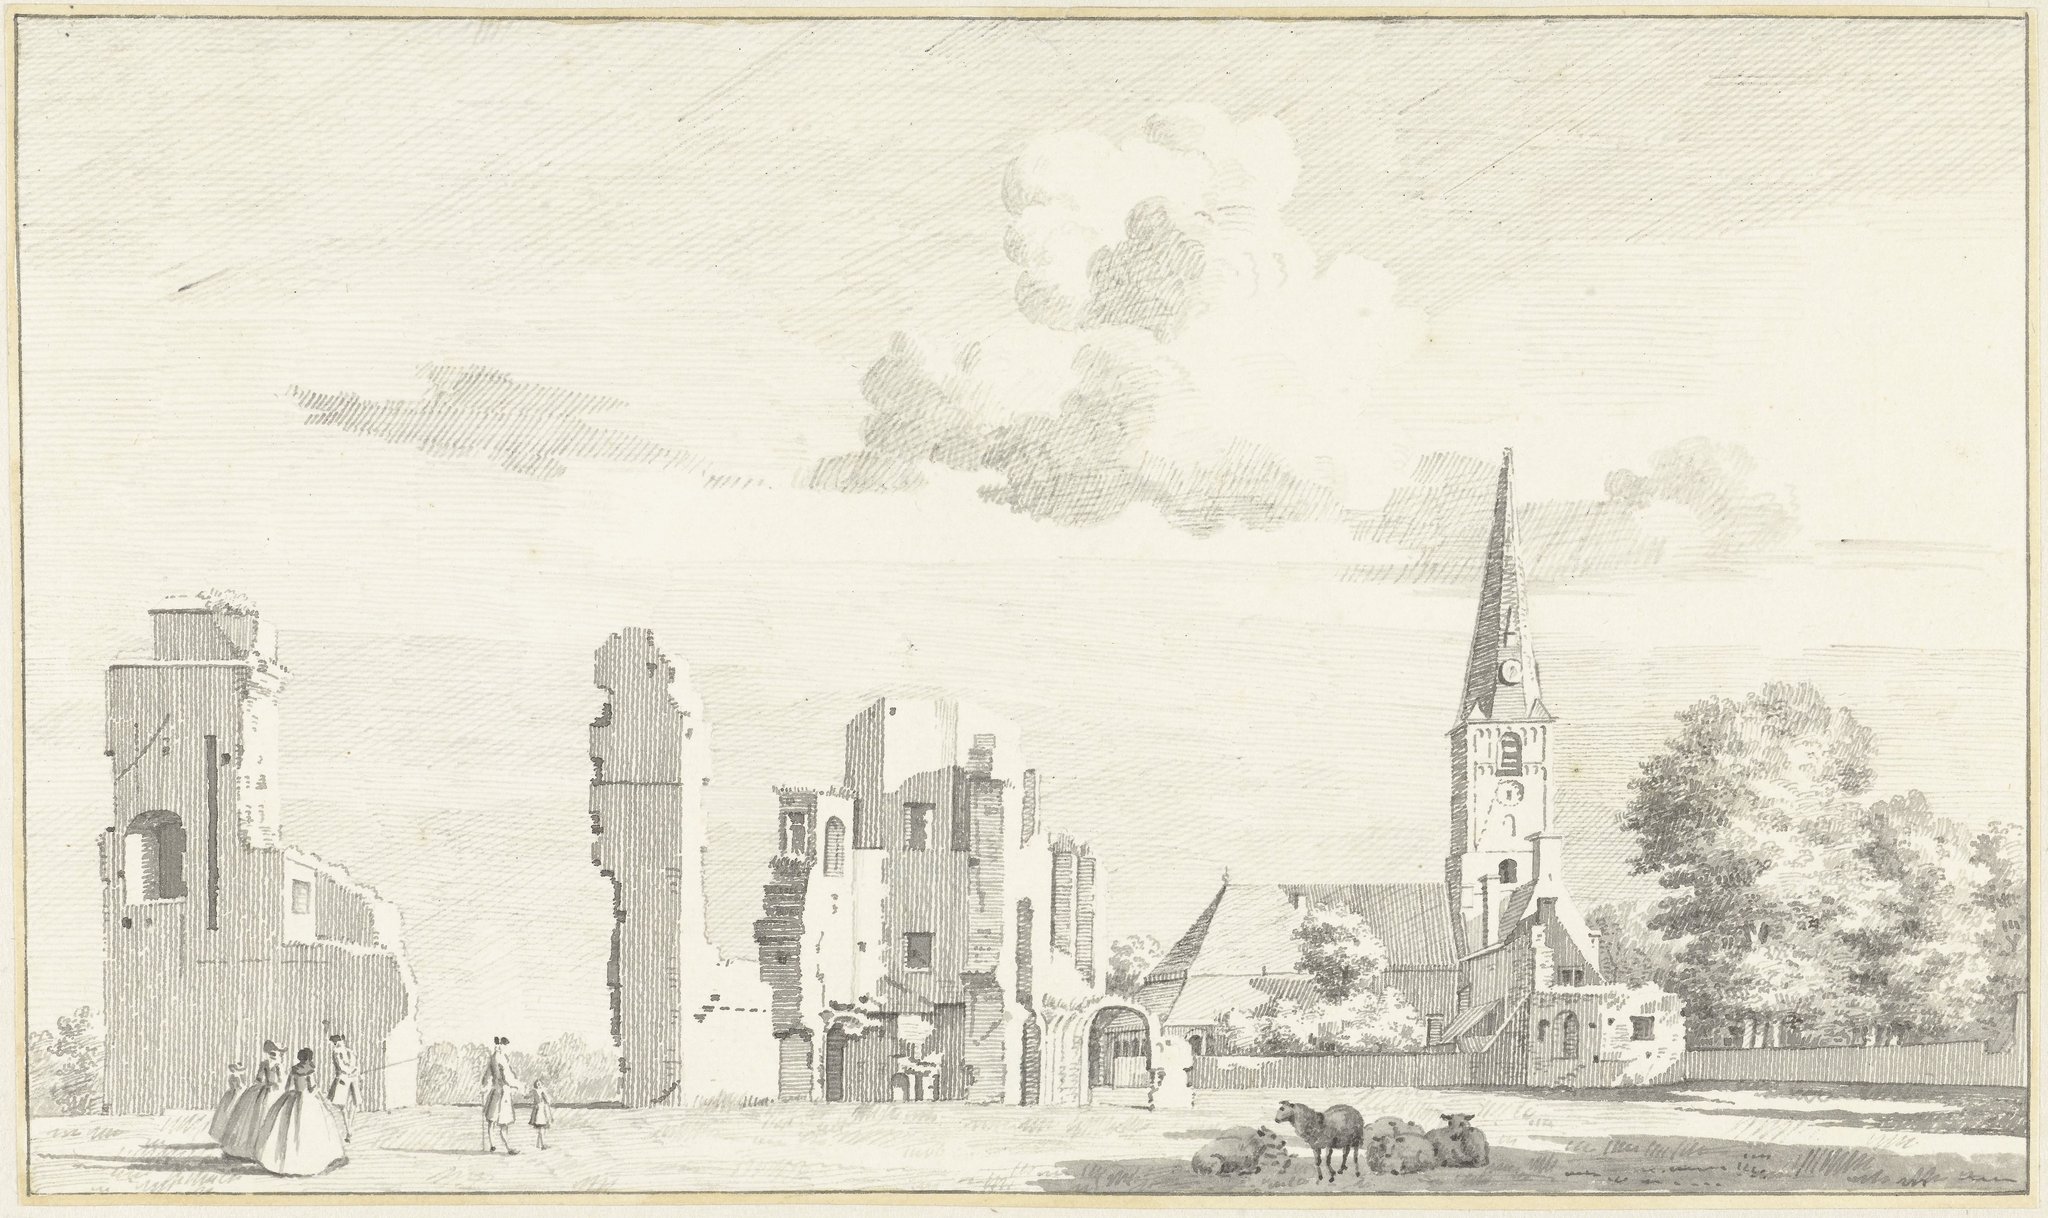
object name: drawing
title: Ruïne van de abdij van Rijnsburg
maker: hendrik de winter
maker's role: draughtsman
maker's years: 1717-1790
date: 1727-1790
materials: ink, paper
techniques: brush, pen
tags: ruin of church, monastery, etc.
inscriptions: inscription: ‘Gezigt van de Ruïnen der Abdy te Rynsburg, met verscheide stoffagie, fiks met de pen gearceerd, door H. de Winter’